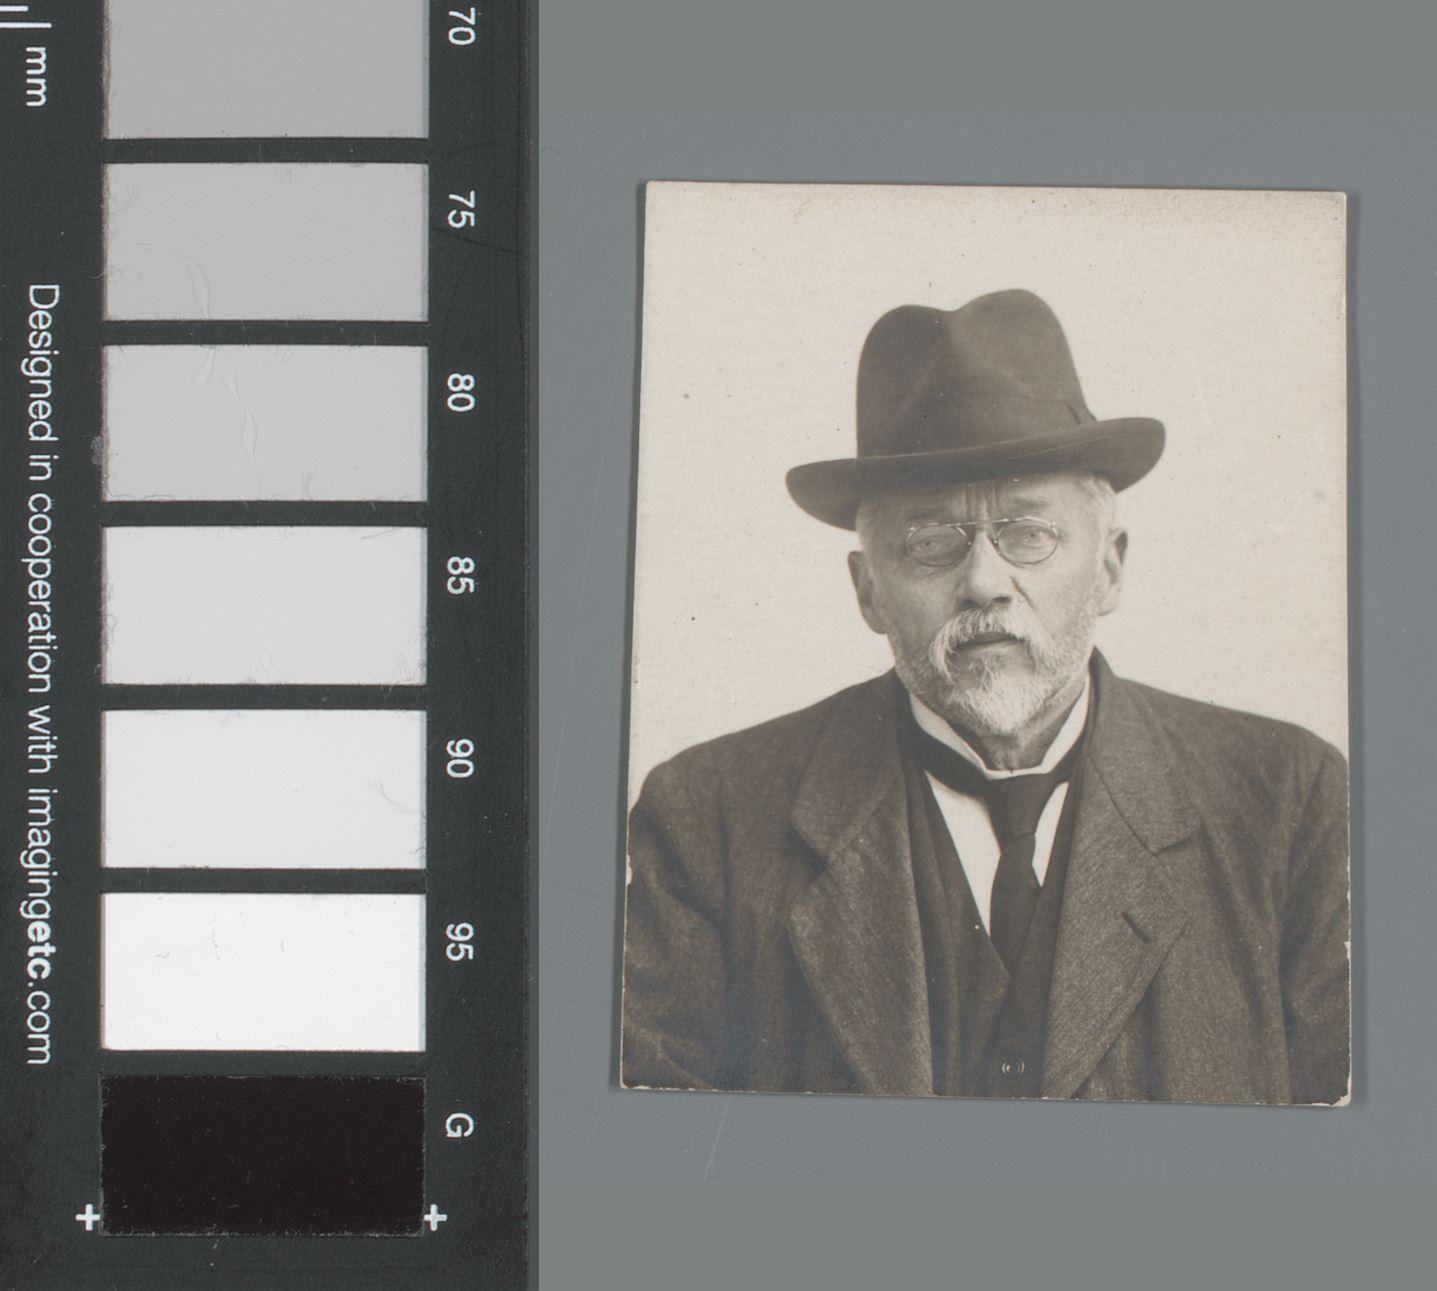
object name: photograph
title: Portret van Lucas Jonker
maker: Anonymous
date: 1925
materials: photographic support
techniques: gelatin silver print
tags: historical persons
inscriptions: date: ‘mei' 1925’